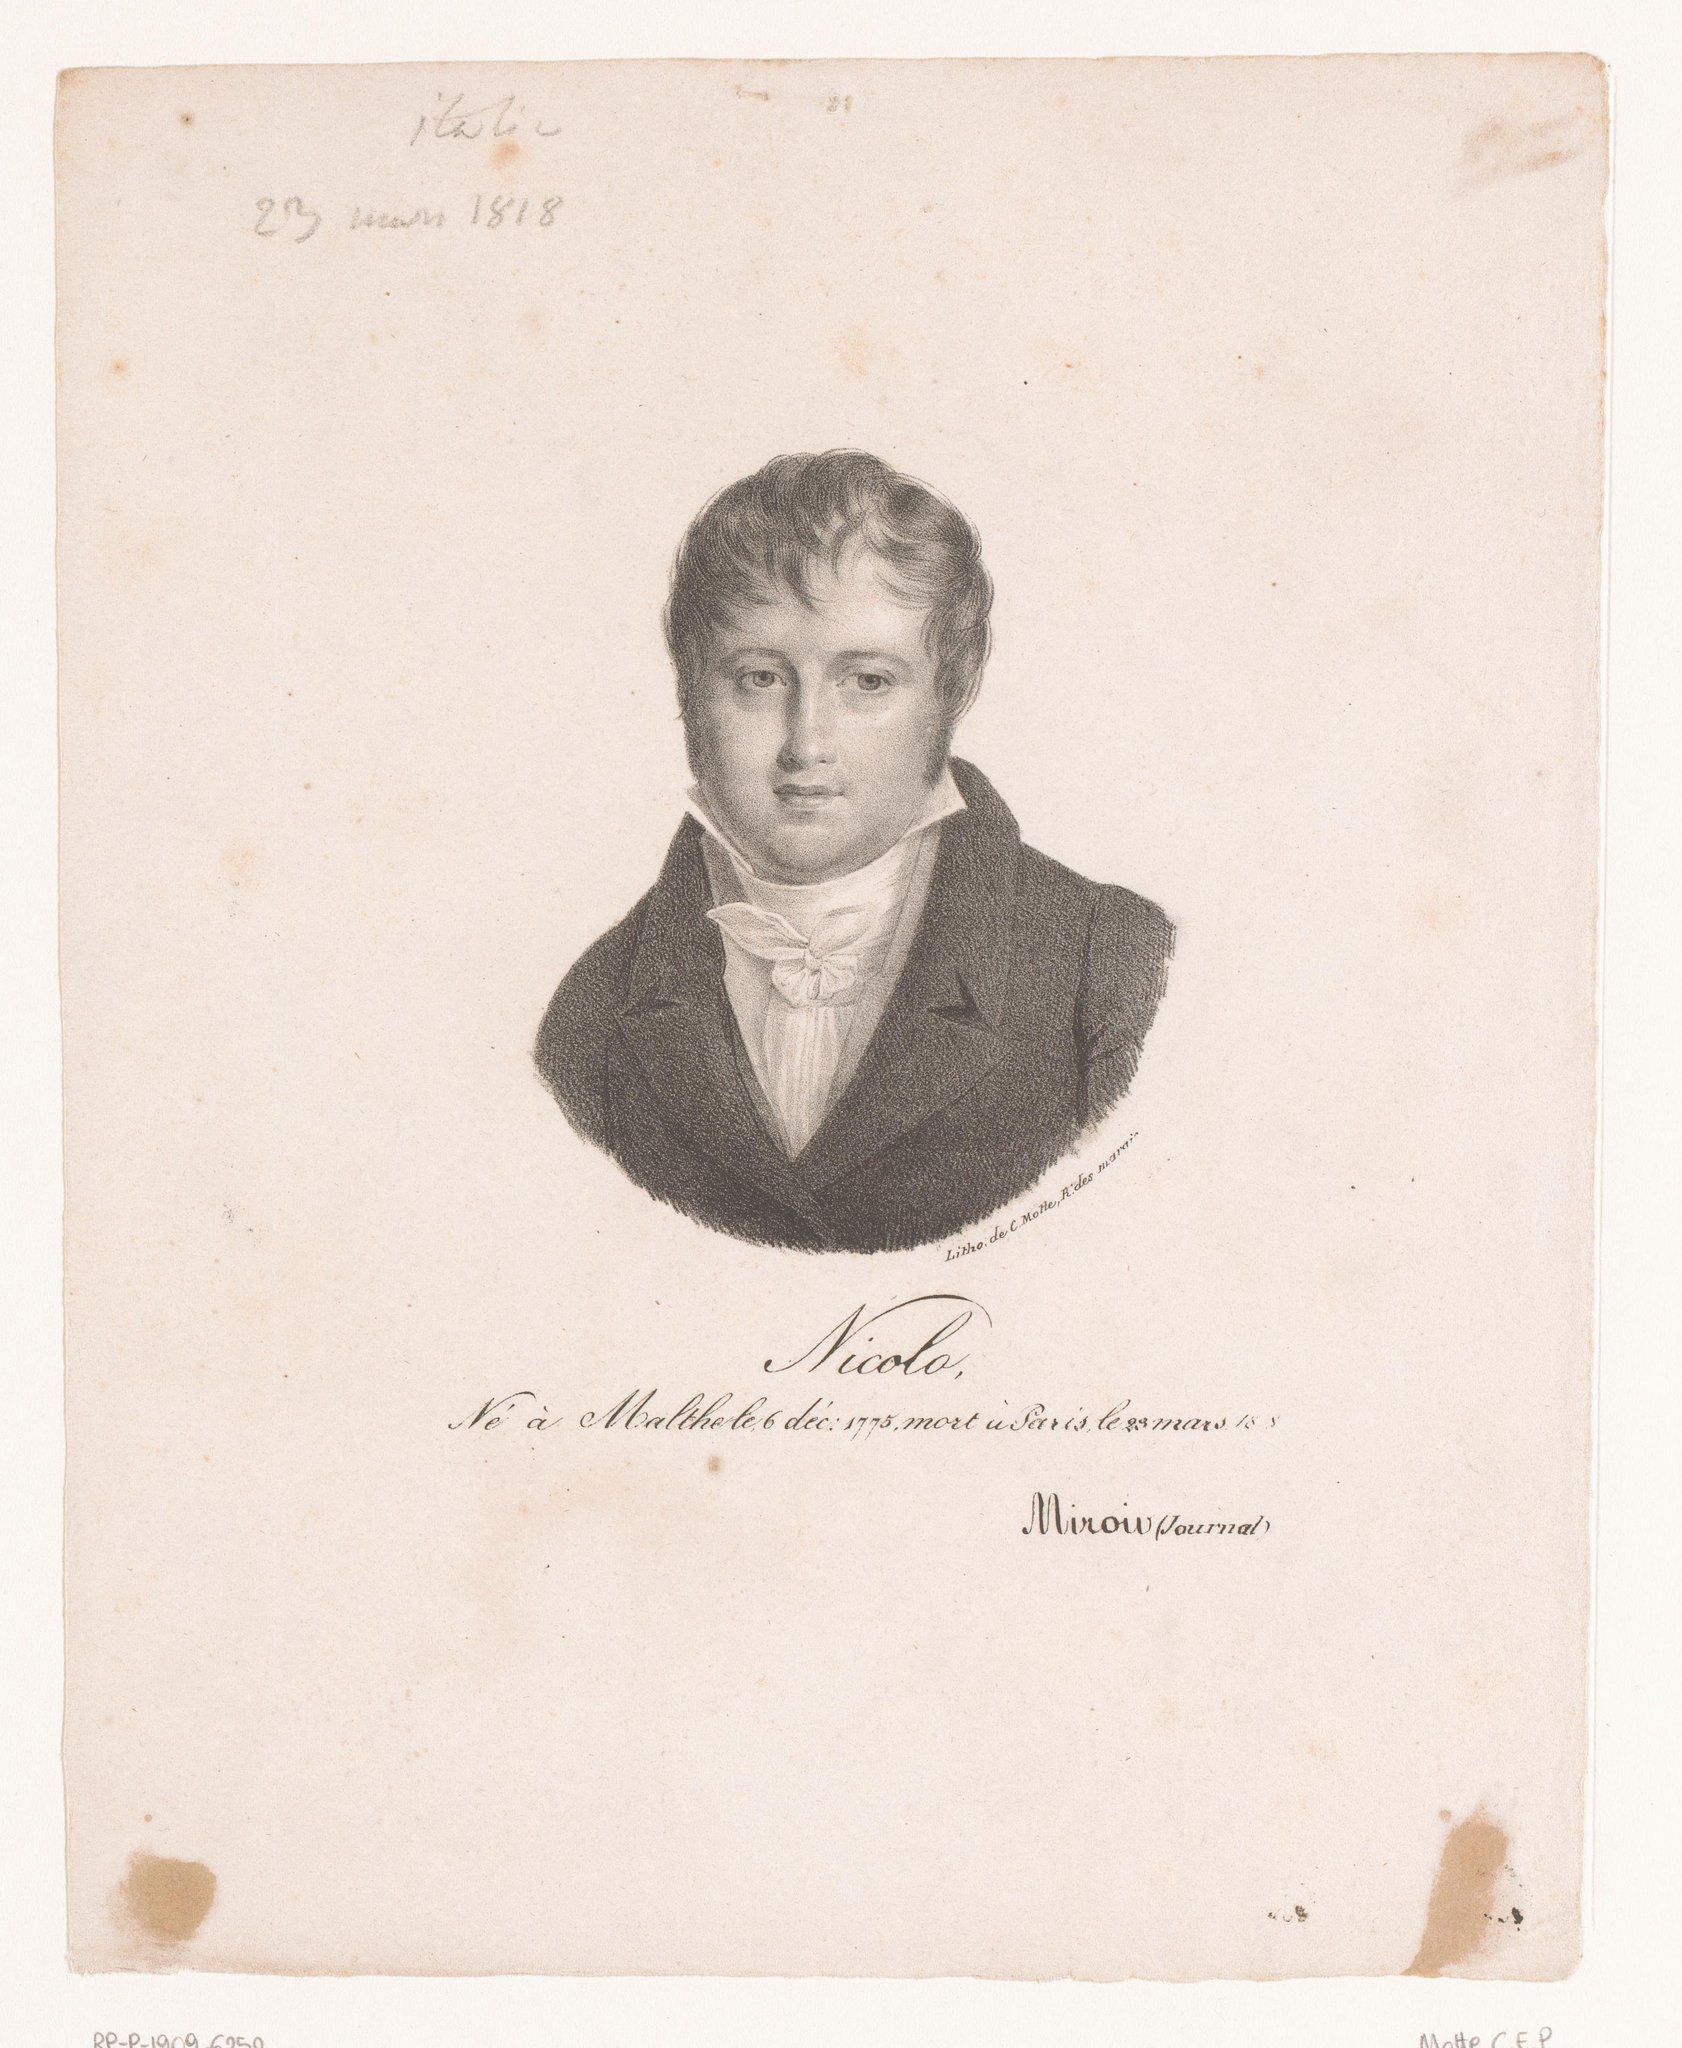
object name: print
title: Portret van Nicolas Isouard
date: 1821-1823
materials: paper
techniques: lithograph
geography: paris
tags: paris, historical persons, portrait of composer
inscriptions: collector's mark: Lugt 2228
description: Prent gebruikt in: Le Miroir des spectacles, des lettres, des mœurs et des arts, 1821-1823.